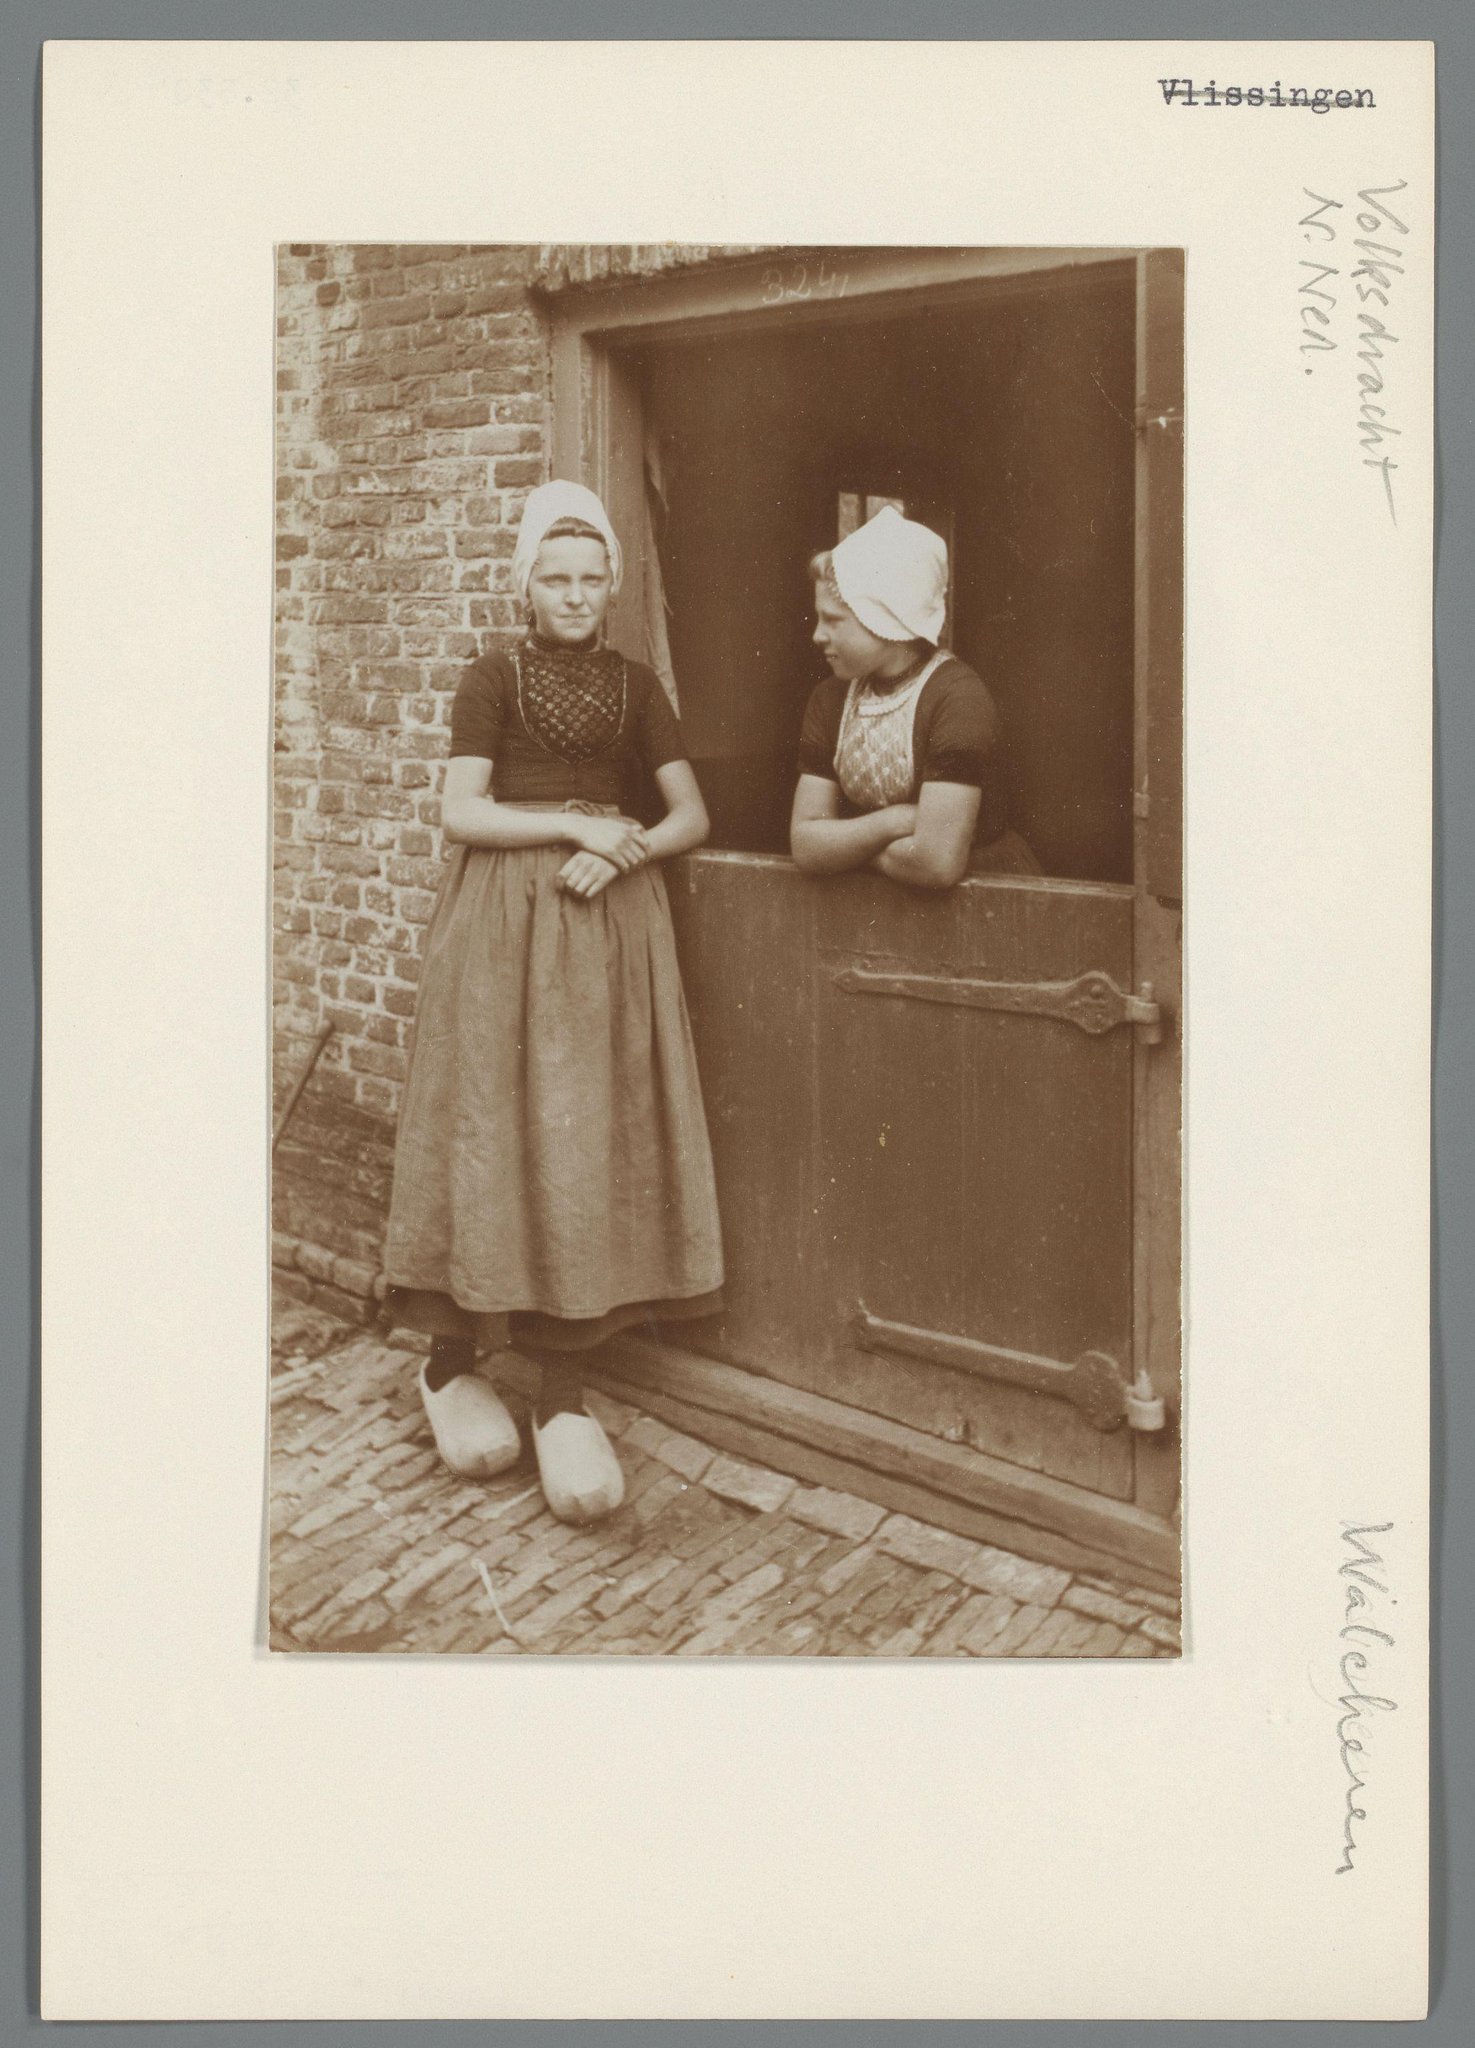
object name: photograph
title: Vlissingen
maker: Anonymous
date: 1880-1920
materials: paper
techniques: collodion silver print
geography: walcheren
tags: well, historical persons, folk costume, regional costume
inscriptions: inscription: ‘Volksdracht/ N.Ned./ Walcheren’, number: ‘32.830’, number: ‘- 527078’